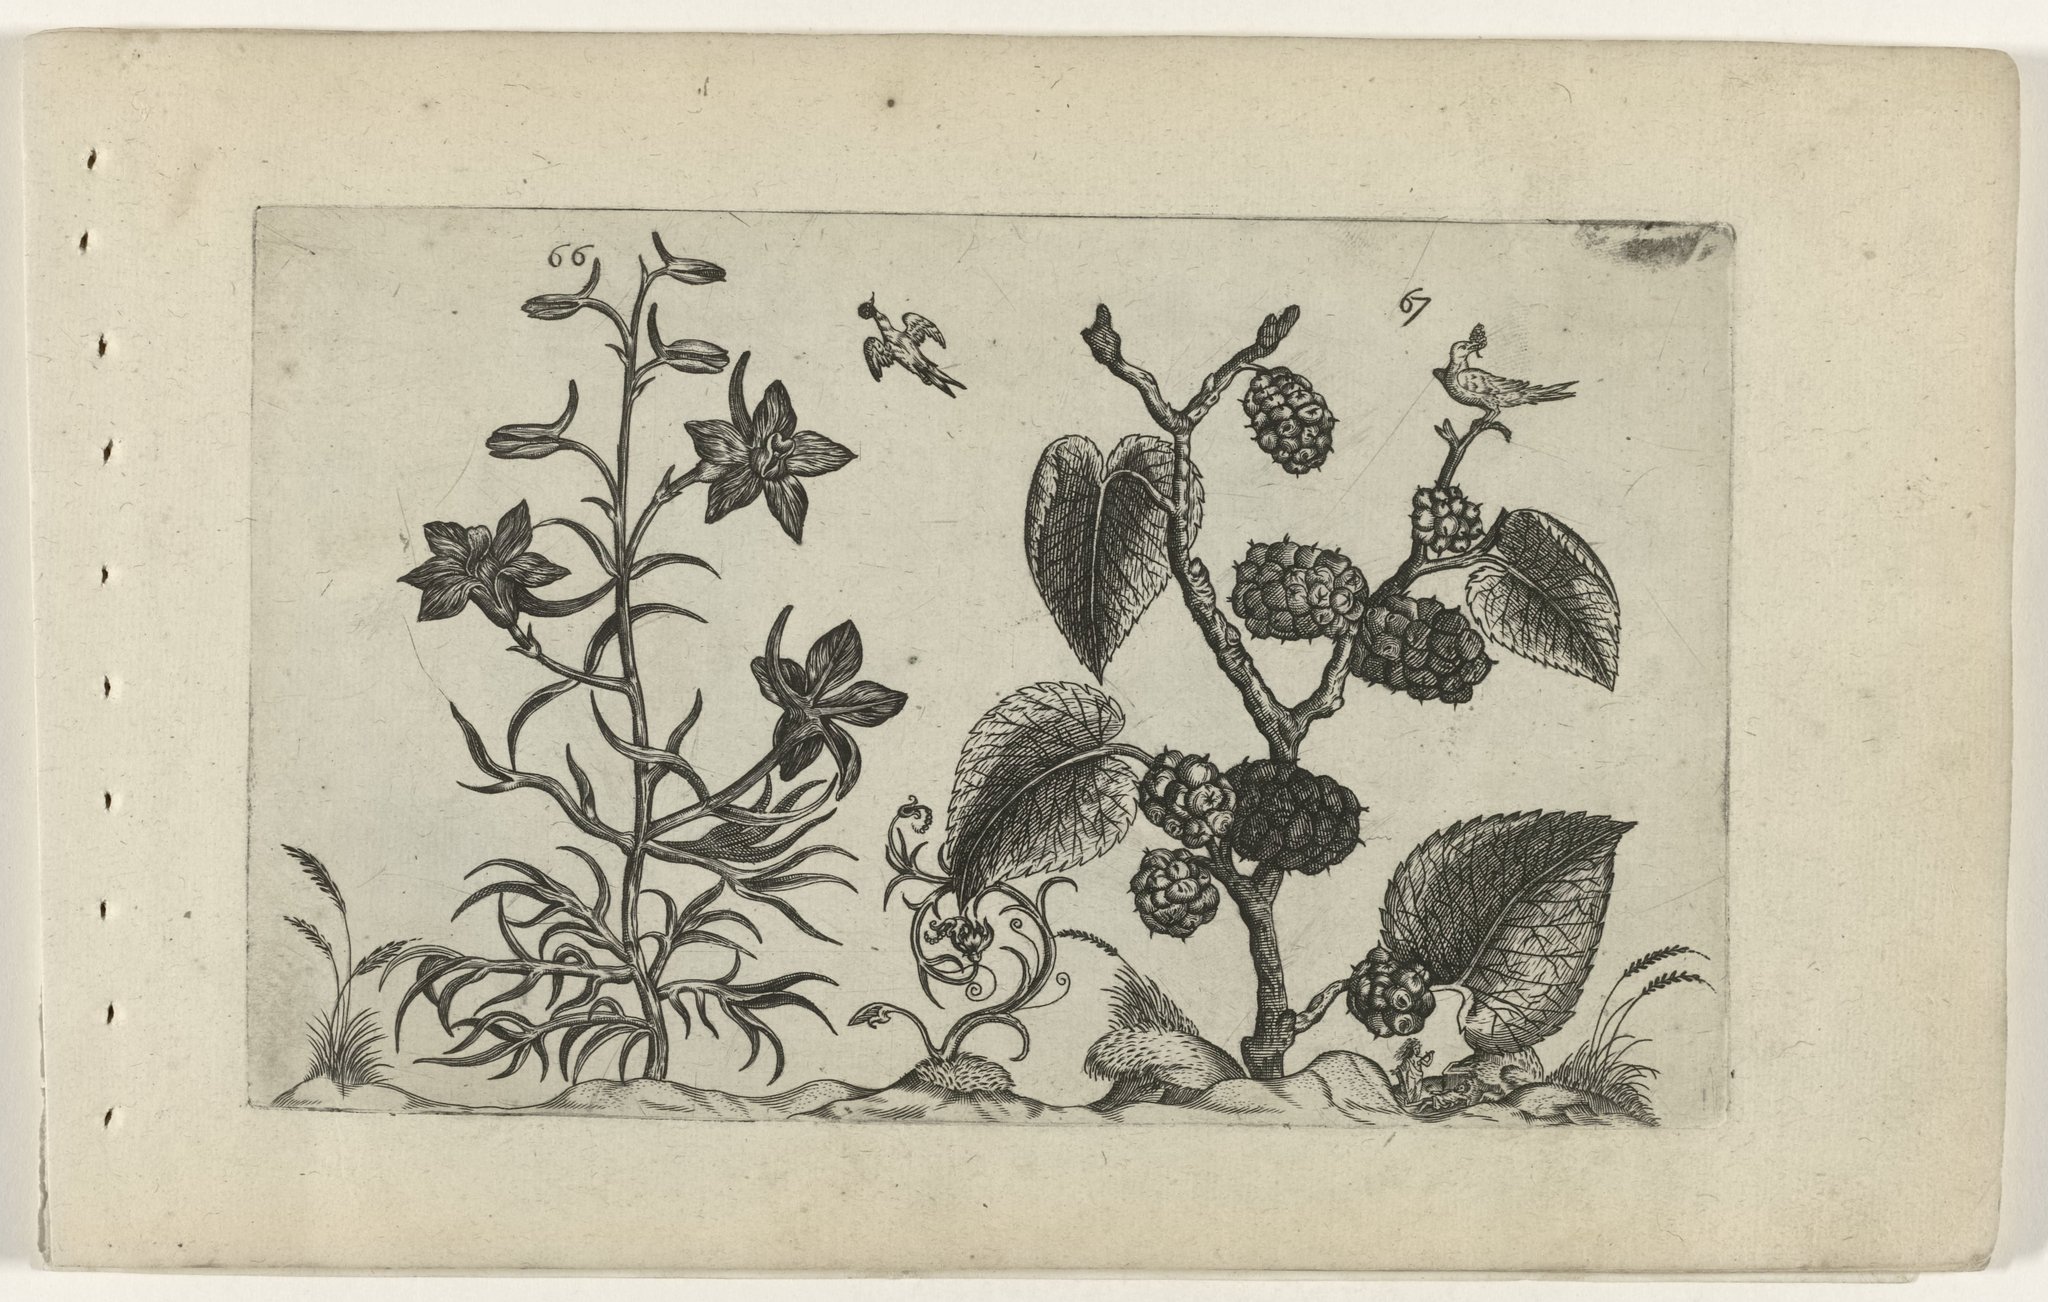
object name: album leaf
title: Wilde ridderspoor en zwarte moerbei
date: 1600-1604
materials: paper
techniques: engraving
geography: cologne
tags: flowers: delphinium, fruits: mulberry, botany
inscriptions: collector's mark: Lugt 2228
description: De prenten RP-P-2012-24-1 t/m 61 waren oorspronkelijk als serie samengebonden. De naaigaten op de bladen zijn nog zichtbaar. Het betreft de reeks getiteld: Cognoscite lilia, bestaande uit een titelprent en 60 gravures met 119 genummerde weergaven van planten, bloemen en vruchten, versierd met rinceaux en kleine voorstellingen van dieren. Het gaat om proefdrukken van deze reeks gravures, voor de opschriften en, deels, voor de nummering. Op enkele prenten zijn de nummers met de hand aangebracht. Op de titelprent ontbreekt nog het adres van Crispijn de Passe en Hans Woutneel. De titel is hoogstwaarschijnlijk gegraveerd door Matthias Quad. Deze werkte voor De Passe in Keulen tot 1604. De reeks moet in dit jaar of daarvoor tot stand zijn gebracht. In ieder geval voor 1608, aangezien de uitgever Hans Woutneel in of voor dat jaar overleed. In ieder geval voor 1608, aangezien de uitgever Hans Woutneel in of voor dat jaar overleed. De gravures worden door Ilja Veldman en Anthony Griffiths beschouwd als eigenhandig werk van Crispijn de Passe I. Een van de prenten uit de reeks ontbreekt (nr 21-22) en is vervangen door een ingekleurde afdruk uit een latere uitgave (RP-P-2012-24-61), die onder de titel Altera Pars is opgenomen in de Hortus Floridus, uitgegeven door Crispijn de Passe I en die verder bestaat uit platen van Crispijn de Passe II. De prenten afkomstig uit deze uitgave zijn op de verso voorzien van tekst in boekdruk. De vervangende prent maakte geen deel uit van de gebonden serie aangezien dit blad als enige geen naaigaten heeft. Een deel van de planten, bloemen en vruchten in de Cognoscite lilia gaat terug of is gebaseerd op een reeks aquarellen van Jacques LeMoyne uit circa 1580 en uit 1585, nu in het Victoria and Albert Museum en de British Museum (zie P. Hulton, Jacques LeMoyne, Londen 1977, dl 1, p. 156-162 en p. 165-173).